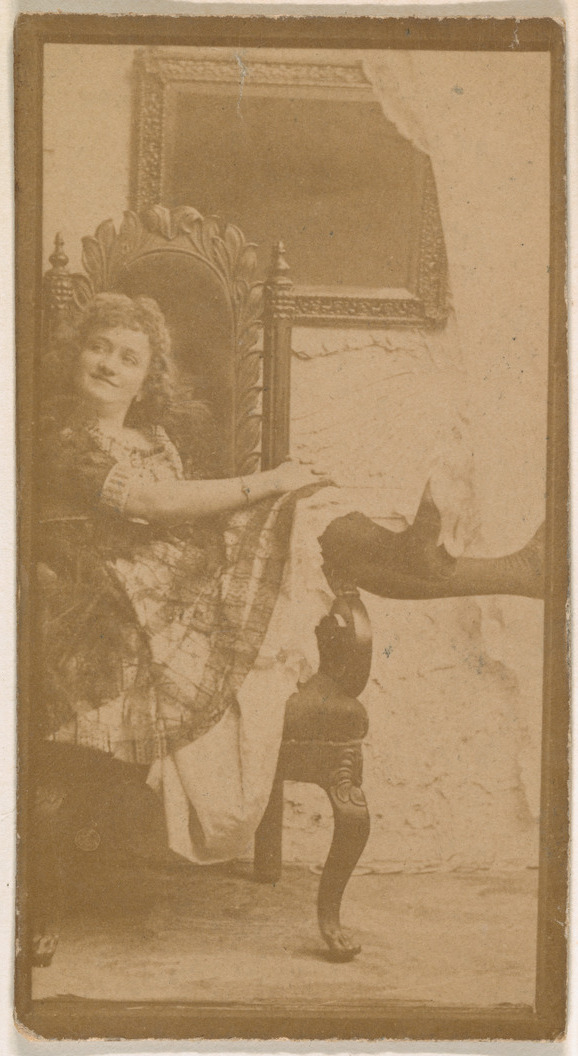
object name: photograph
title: Actress posing on chair with legs resting on armrest, from the Actresses series (N664) promoting Old Fashion Fine Cut Tobacco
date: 1888-1890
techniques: albumen silver print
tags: portraits,women,actresses